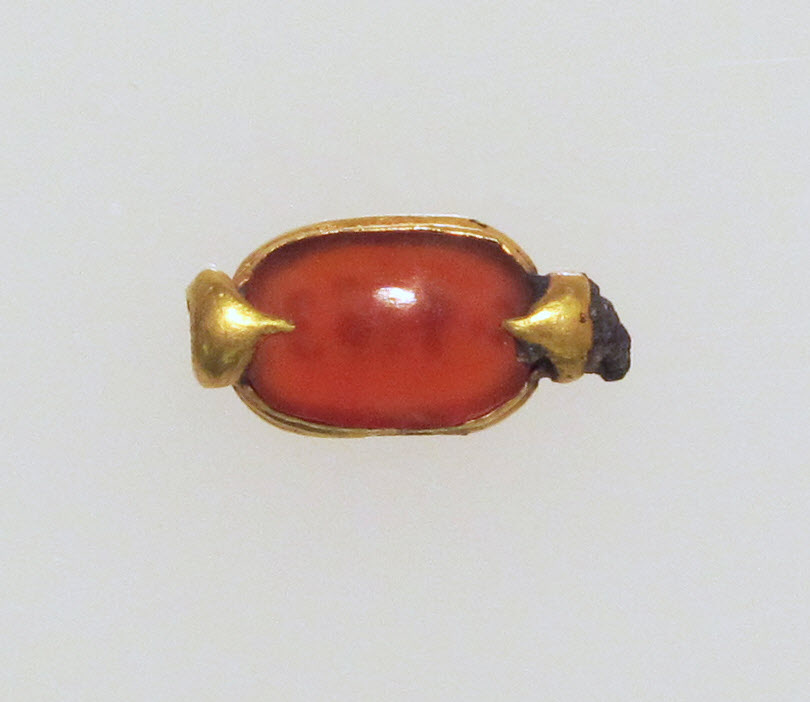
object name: ring bezel with scaraboid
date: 7000 BCE-330 CE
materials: gold